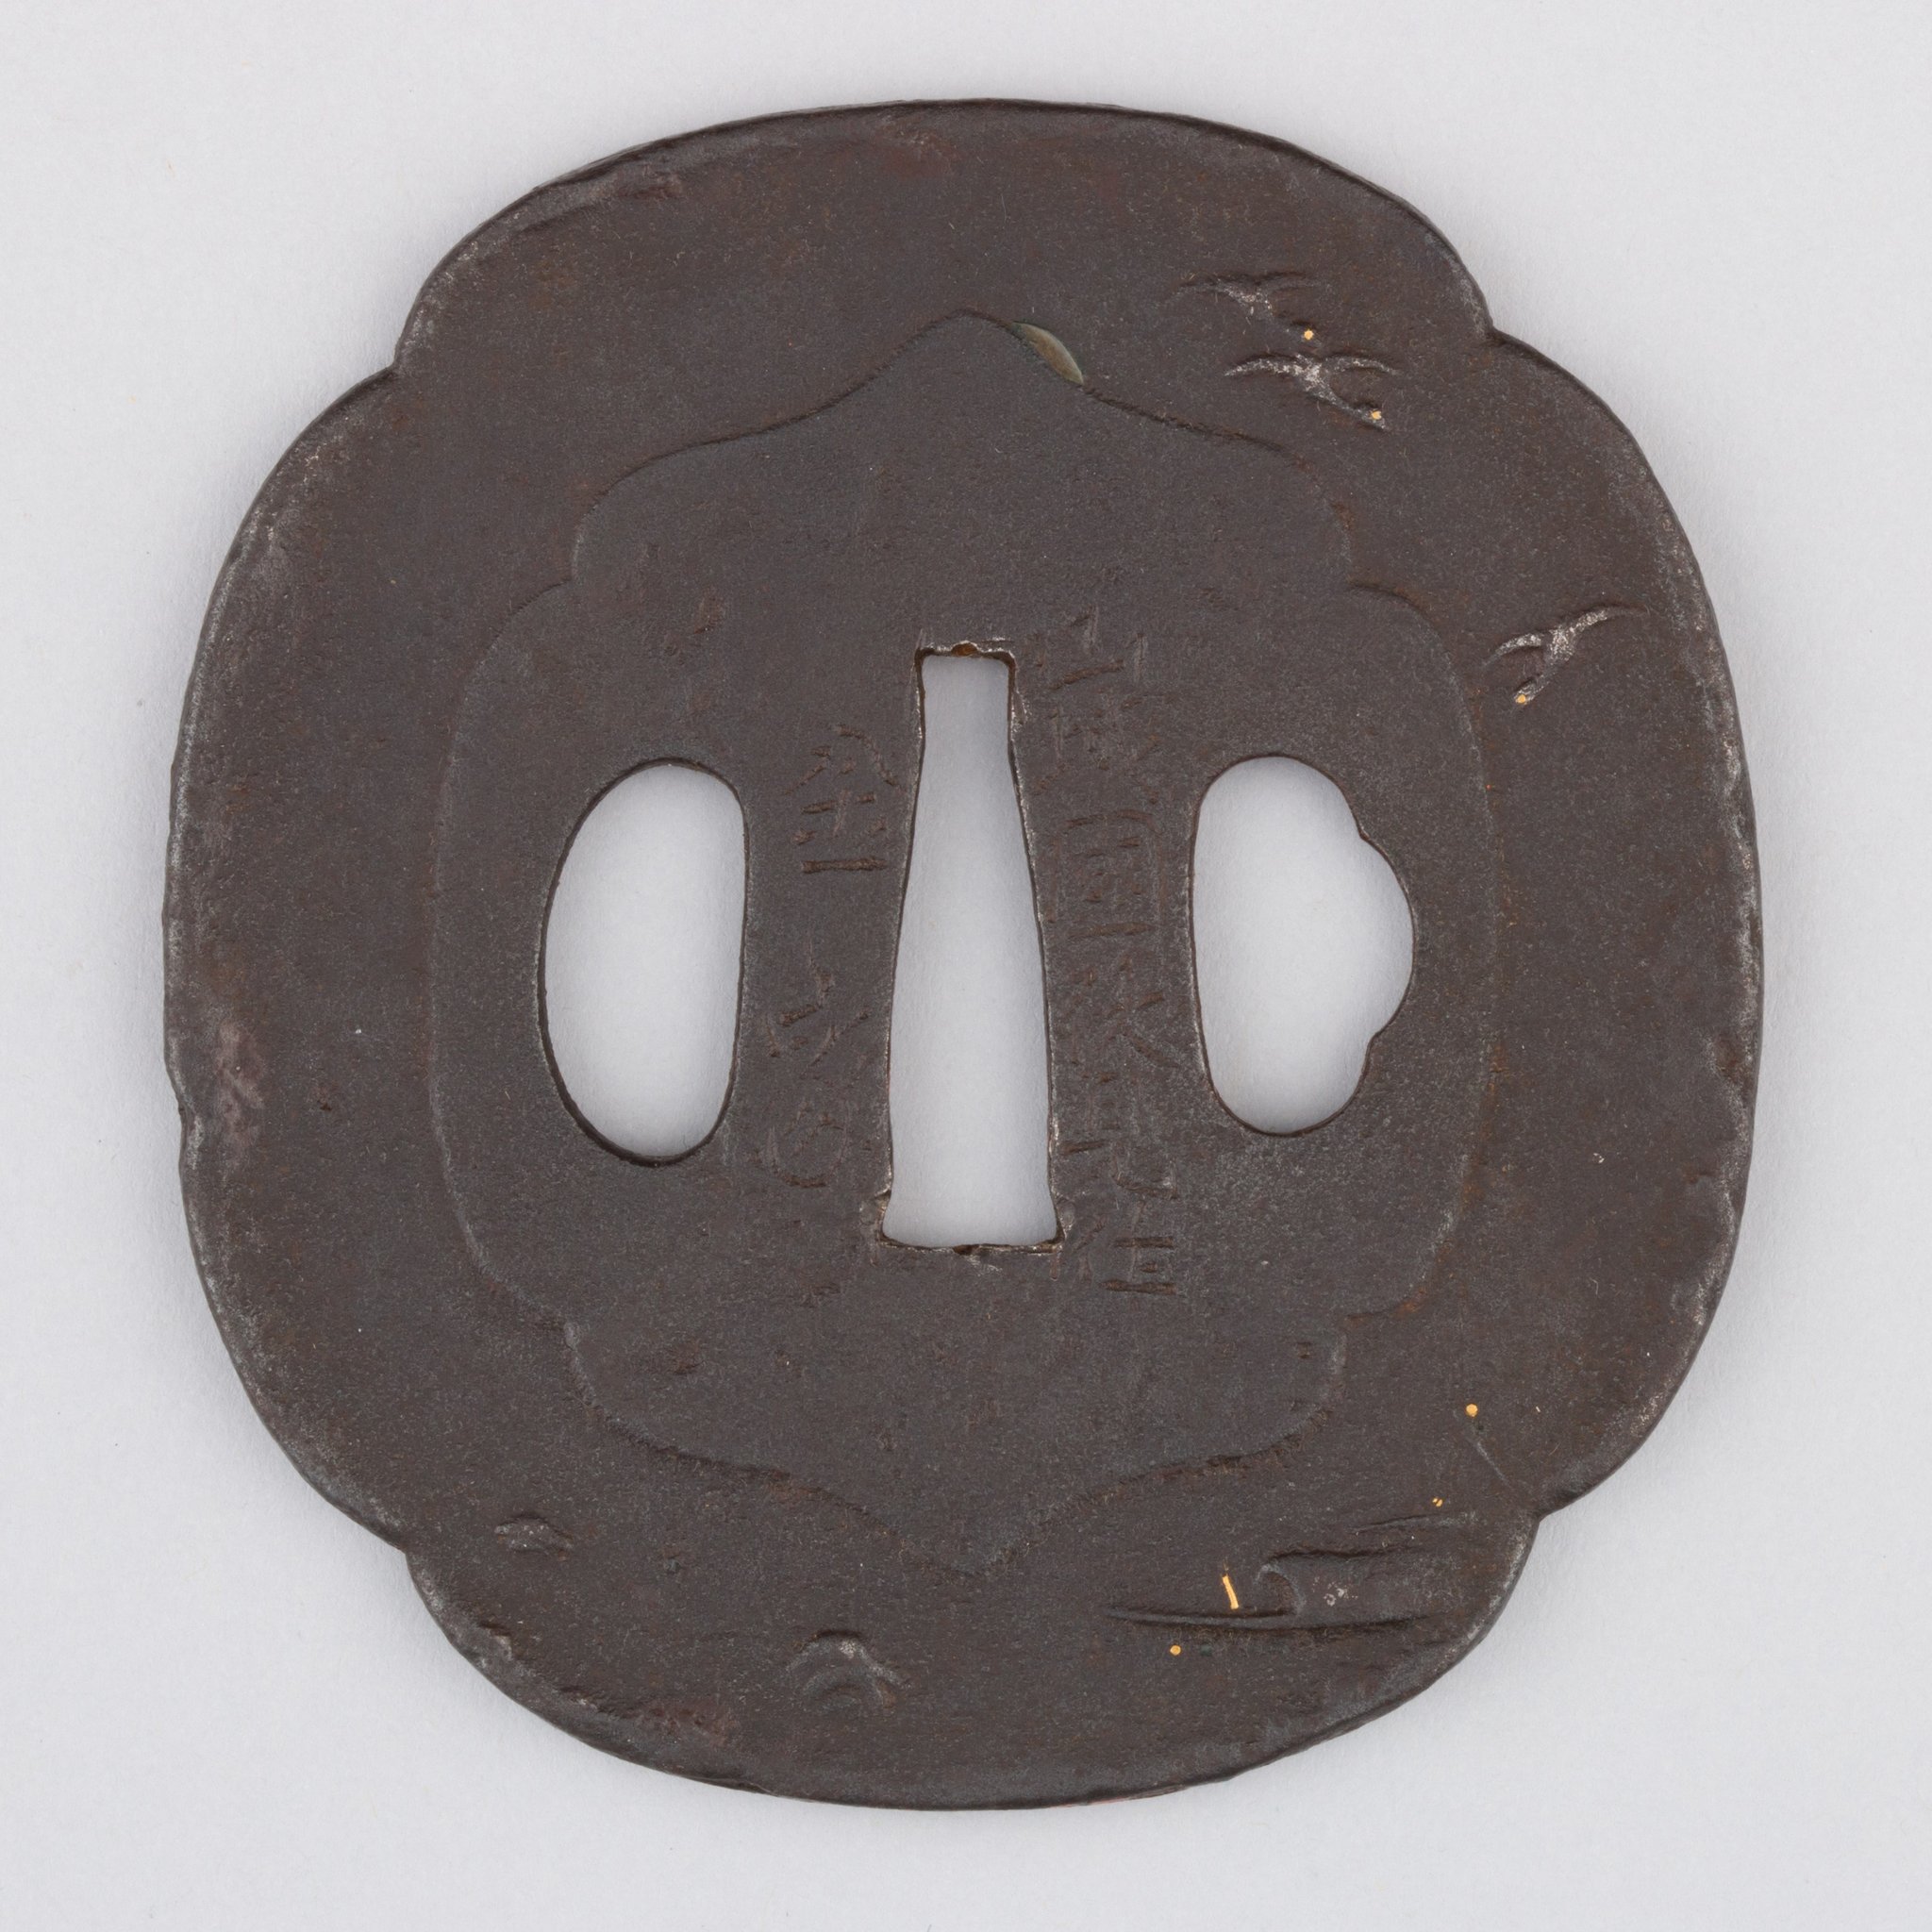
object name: sword guard tsuba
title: Sword Guard (Tsuba)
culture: japanese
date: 1615-1868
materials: copper, iron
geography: japan